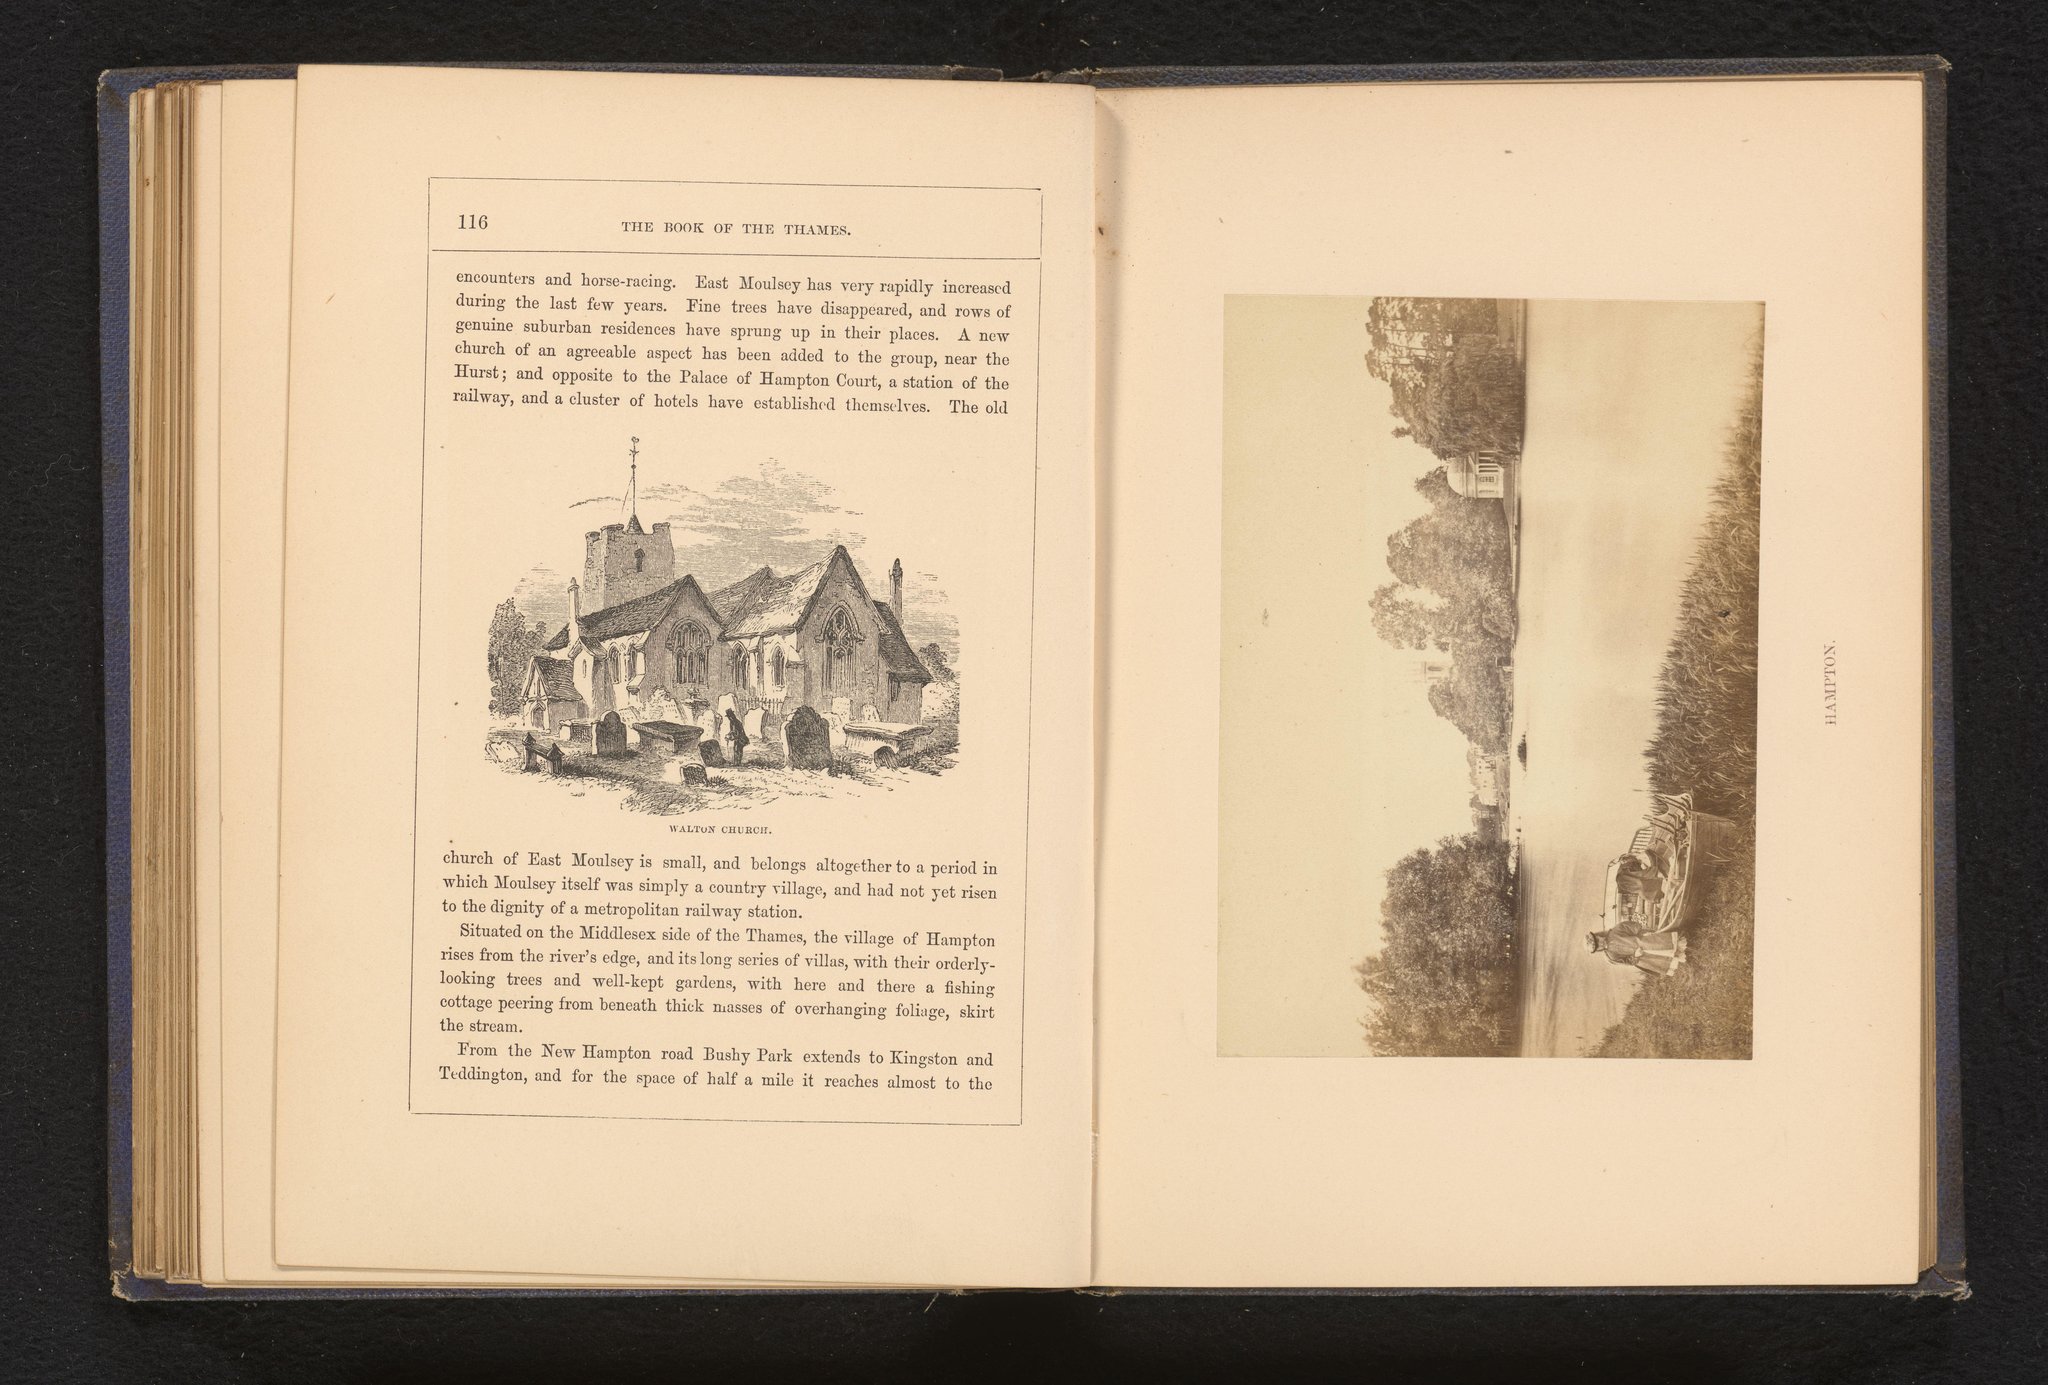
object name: page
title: Gezicht over de Theems bij Hamton in Londen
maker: francis frith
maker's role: publisher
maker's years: 1822-1898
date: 1862-1867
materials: paper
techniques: albumen print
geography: hampton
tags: river, thames